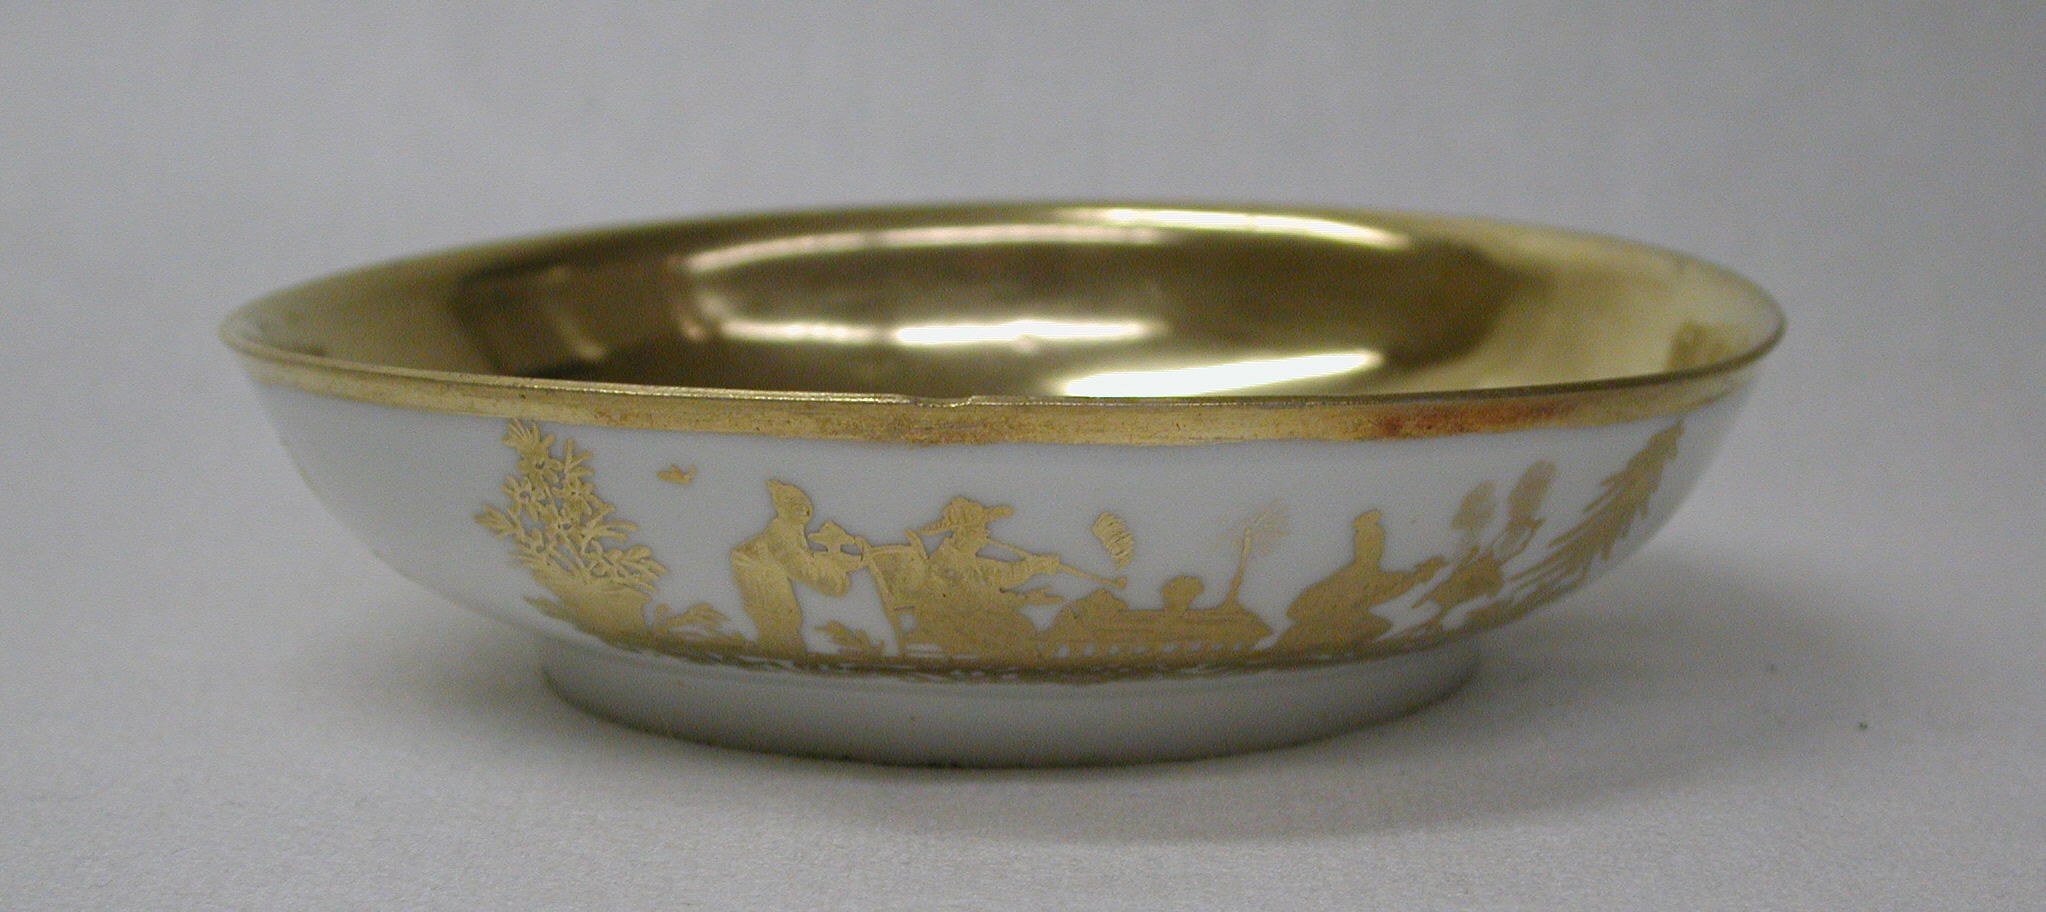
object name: saucer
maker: meissen manufactory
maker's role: manufactory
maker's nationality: german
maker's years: 1710-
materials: hard paste porcelain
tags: human figures,chinoiserie